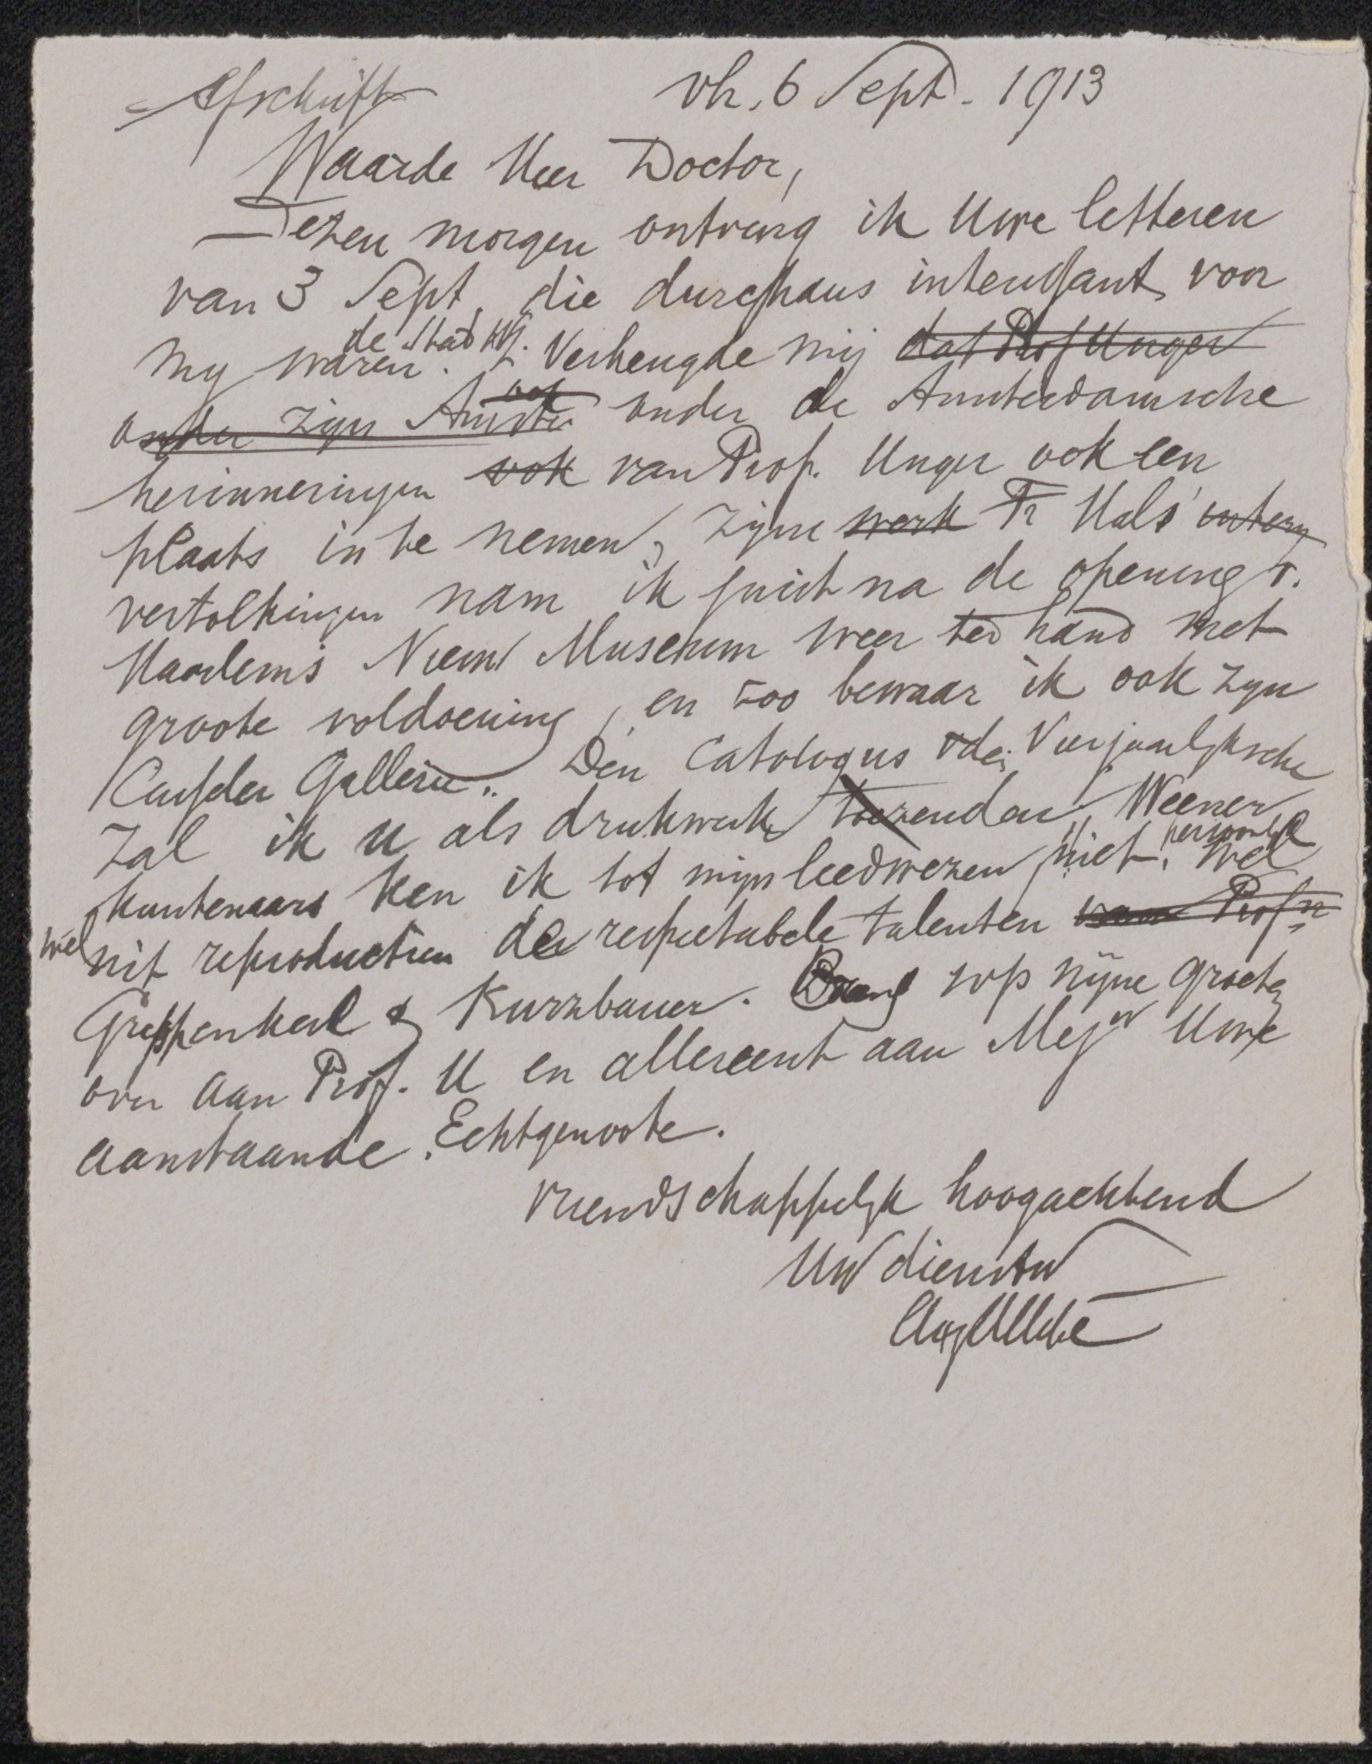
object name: letter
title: Brief aan anoniem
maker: august allebé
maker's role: draughtsman, print maker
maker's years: 1838-1927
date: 1913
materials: ink, paper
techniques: pen, writing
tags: painter, william unger